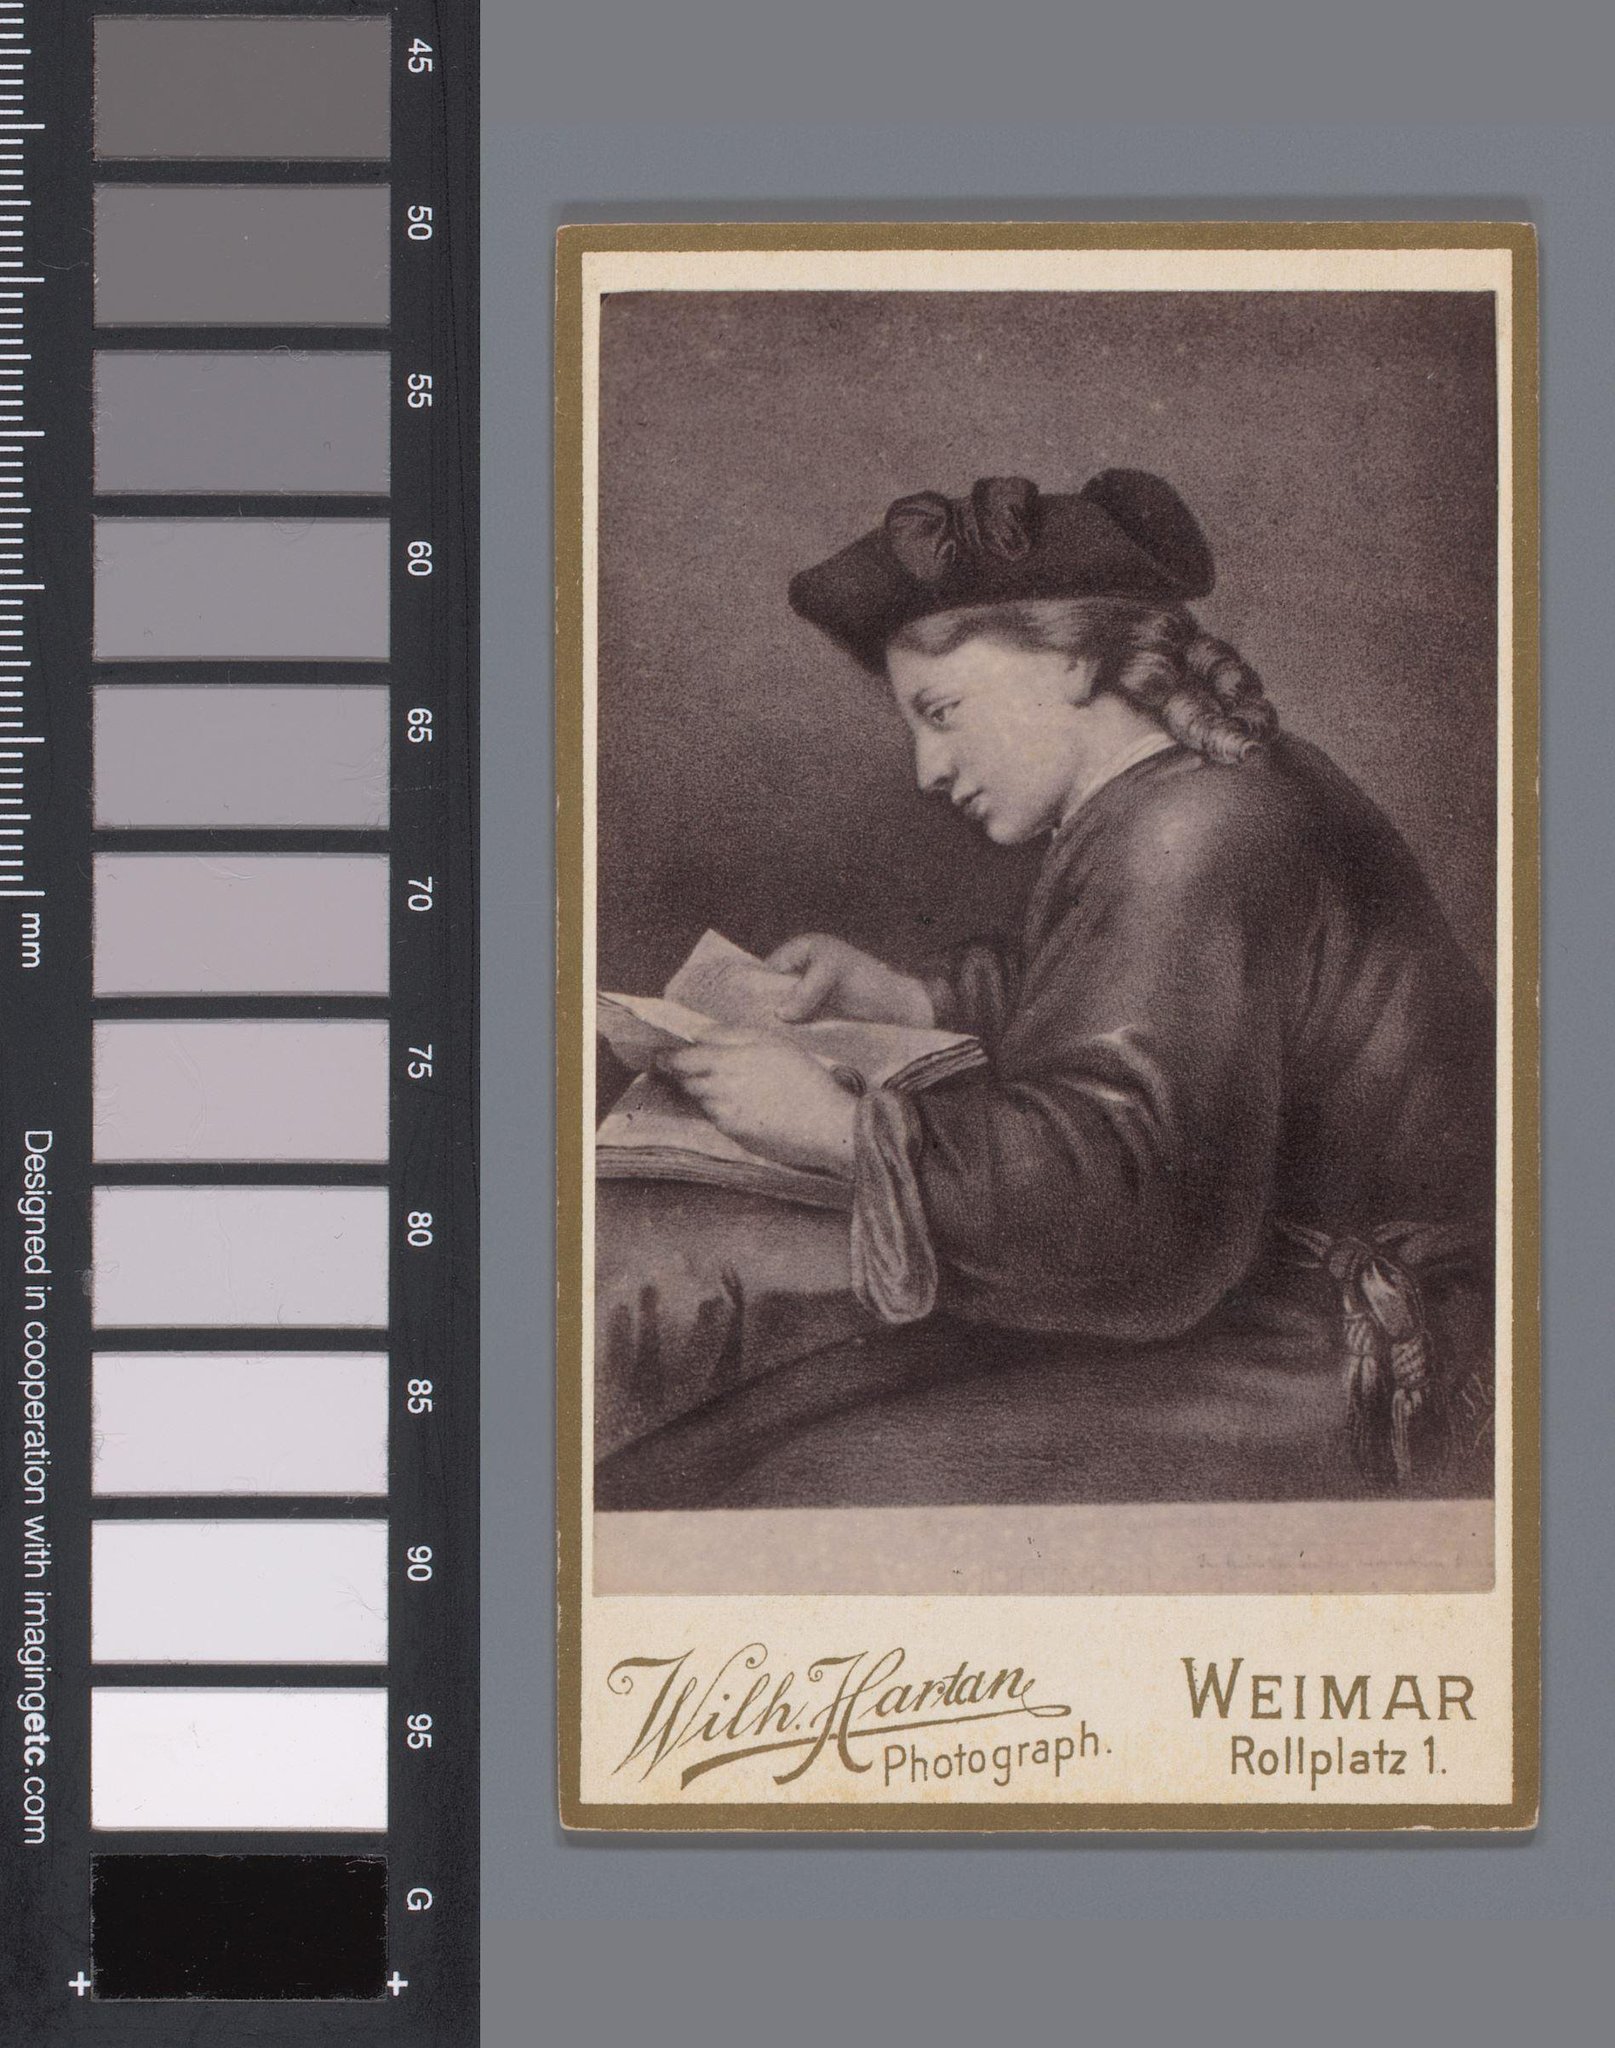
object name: carte de visite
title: Fotoreproductie van een ontwerp van een lezende jongeman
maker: wilhelm hartan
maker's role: publisher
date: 1864-1900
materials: cardboard, paper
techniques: albumen print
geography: weimar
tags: reading, youth, adolescent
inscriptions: address: ‘Rollplatz 1.’